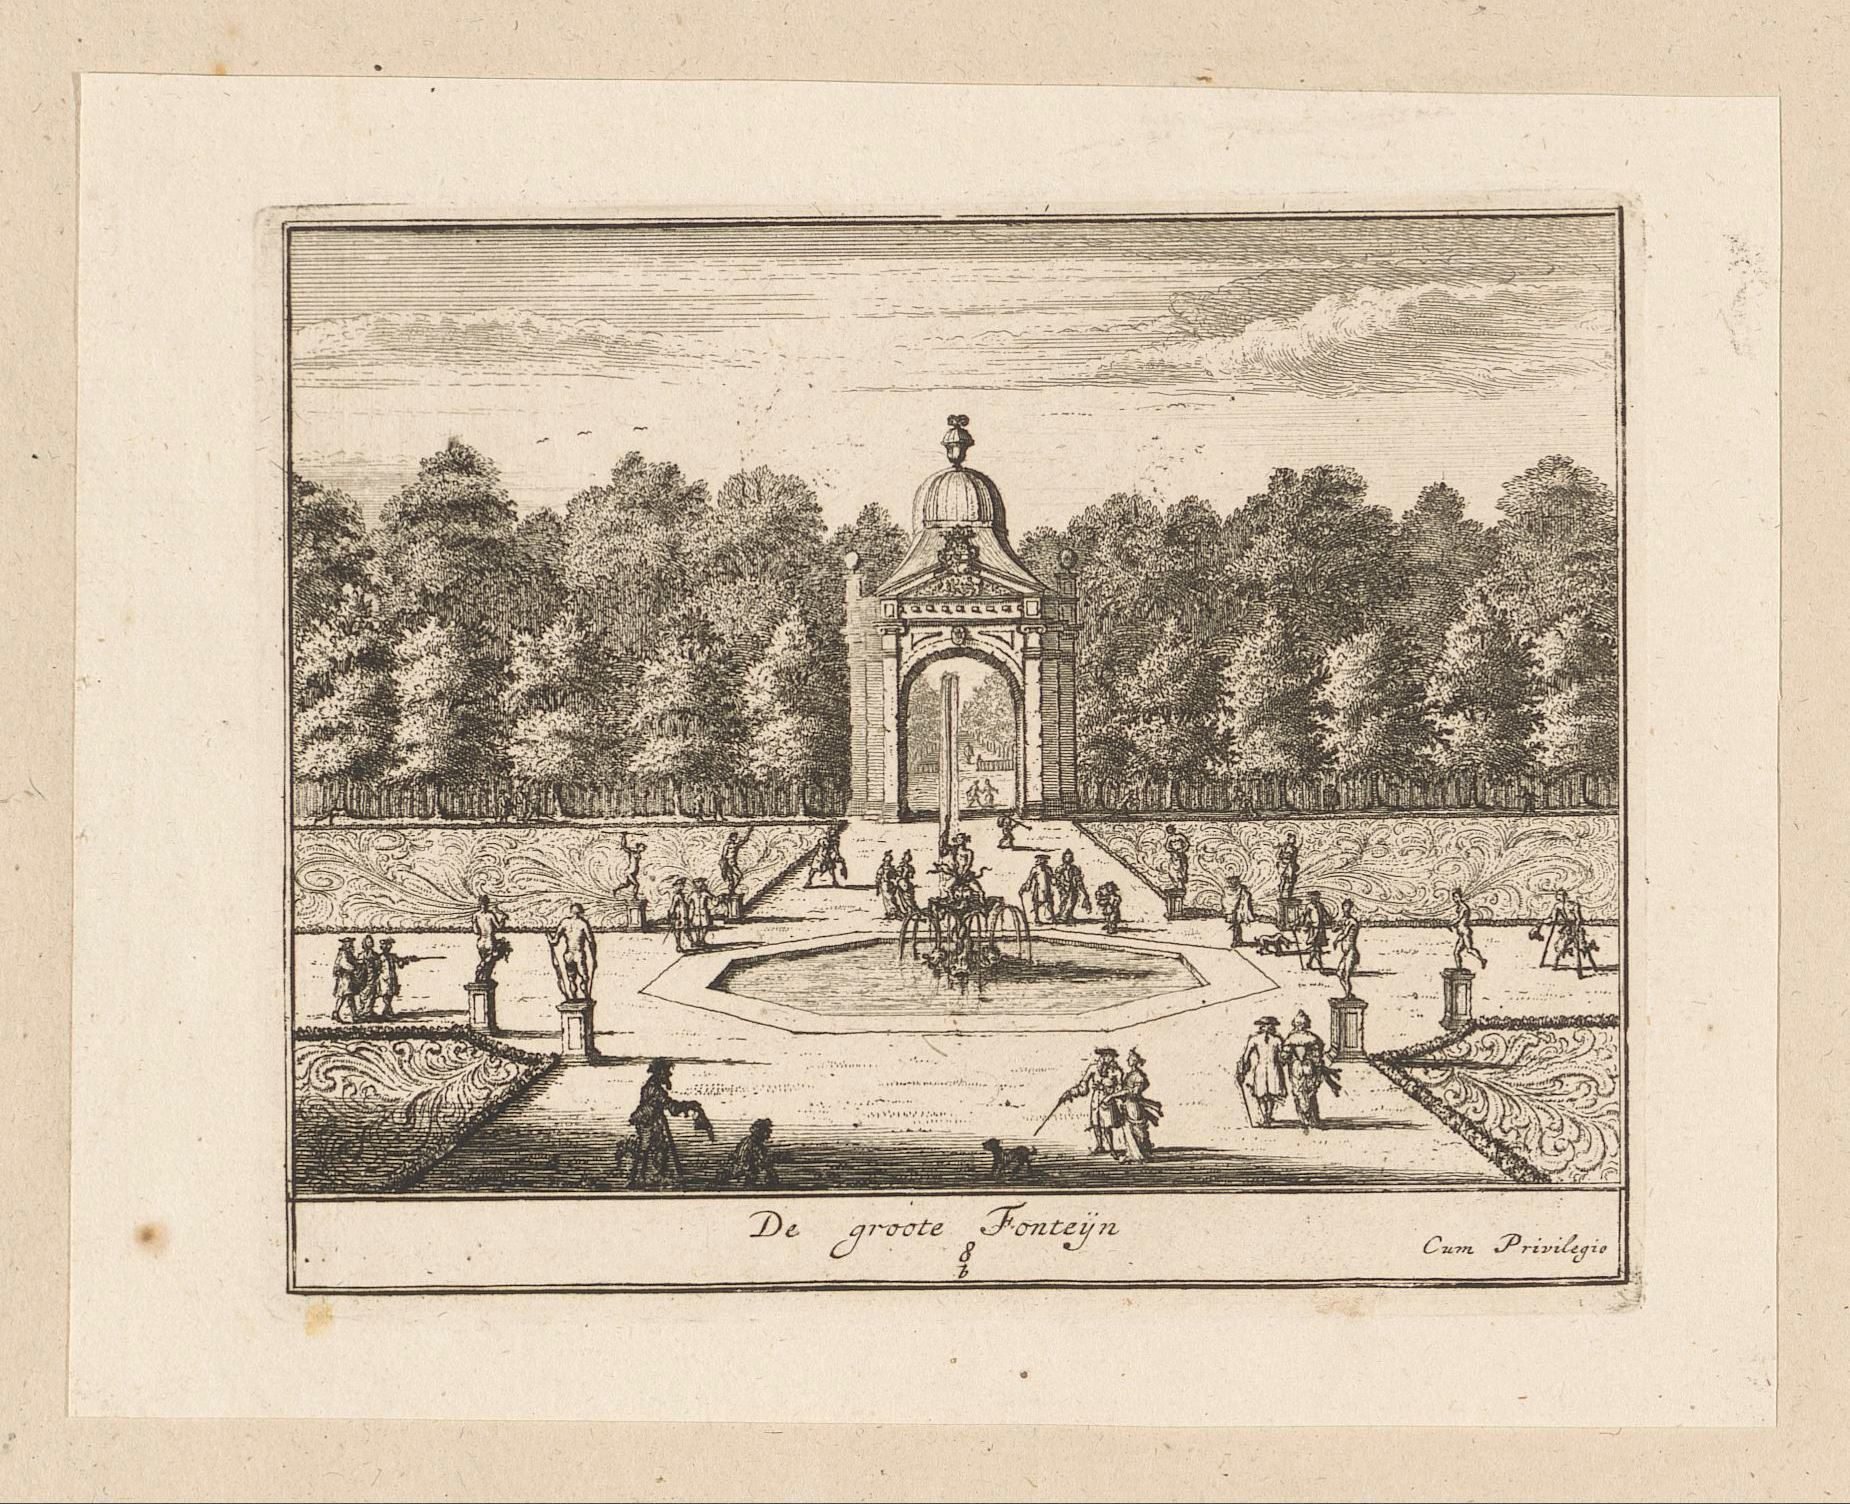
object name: print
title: Tuin van Paleis Honselaarsdijk met beelden en fontein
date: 1695-1757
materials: paper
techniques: engraving, etching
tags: garden fountain, palace, french or architectonic garden; formal garden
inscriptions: collector's mark: Lugt 2233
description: Onderdeel van een serie van zestien prenten van Paleis Honselaarsdijk, oorspronkelijk gemaakt (en waarschijnlijk ook uitgegeven) door Abraham Bloteling rond 1684. Op de eerste staat van de prenten stond zijn naam linksonder, de sporen hiervan zijn met name op de negende prent (RP-P-AO-11-80-9B) nog duidelijk te zien. Deze staat van de serie is zeldzaam, mogelijk bezit de Bibliothèque Nationale een exemplaar. Zijn schoonbroer Gerard Valck heeft de reeks vervolgens in 1695 uitgegeven samen met drie andere prentseries onder de titel 'Veues et perspectives de Loo, Honslardyck et Soesdyck, chasteaux & maisons de plaisance du Roy de la Grande Bretagne, ausquels on a adjoûté les veuës des environs de Cleves', met voor de prenten van Honselaarsdijk de subtitel 'Veues et perspectives de Honslardyck, chasteau et maison de plaisance du Roy de la Grande Bretagne, le tout dessiné & gravé par les plus habiles maistres'. Valck heeft de platen aangepast waardoor van elke prent een tweede staat ontstond. Vervolgens zijn de platen in handen van Isaac Greve gekomen, die de serie nog een keer uitgaf onder de titel '16. gesigte van 't koninglyke lust huys Honslardyk'. Vermoedelijk heeft Greve alleen de plaat van de eerste prent bijgewerkt en de rest onveranderd gelaten waardoor van de eerste prent drie staten bekend zijn en van de rest twee.